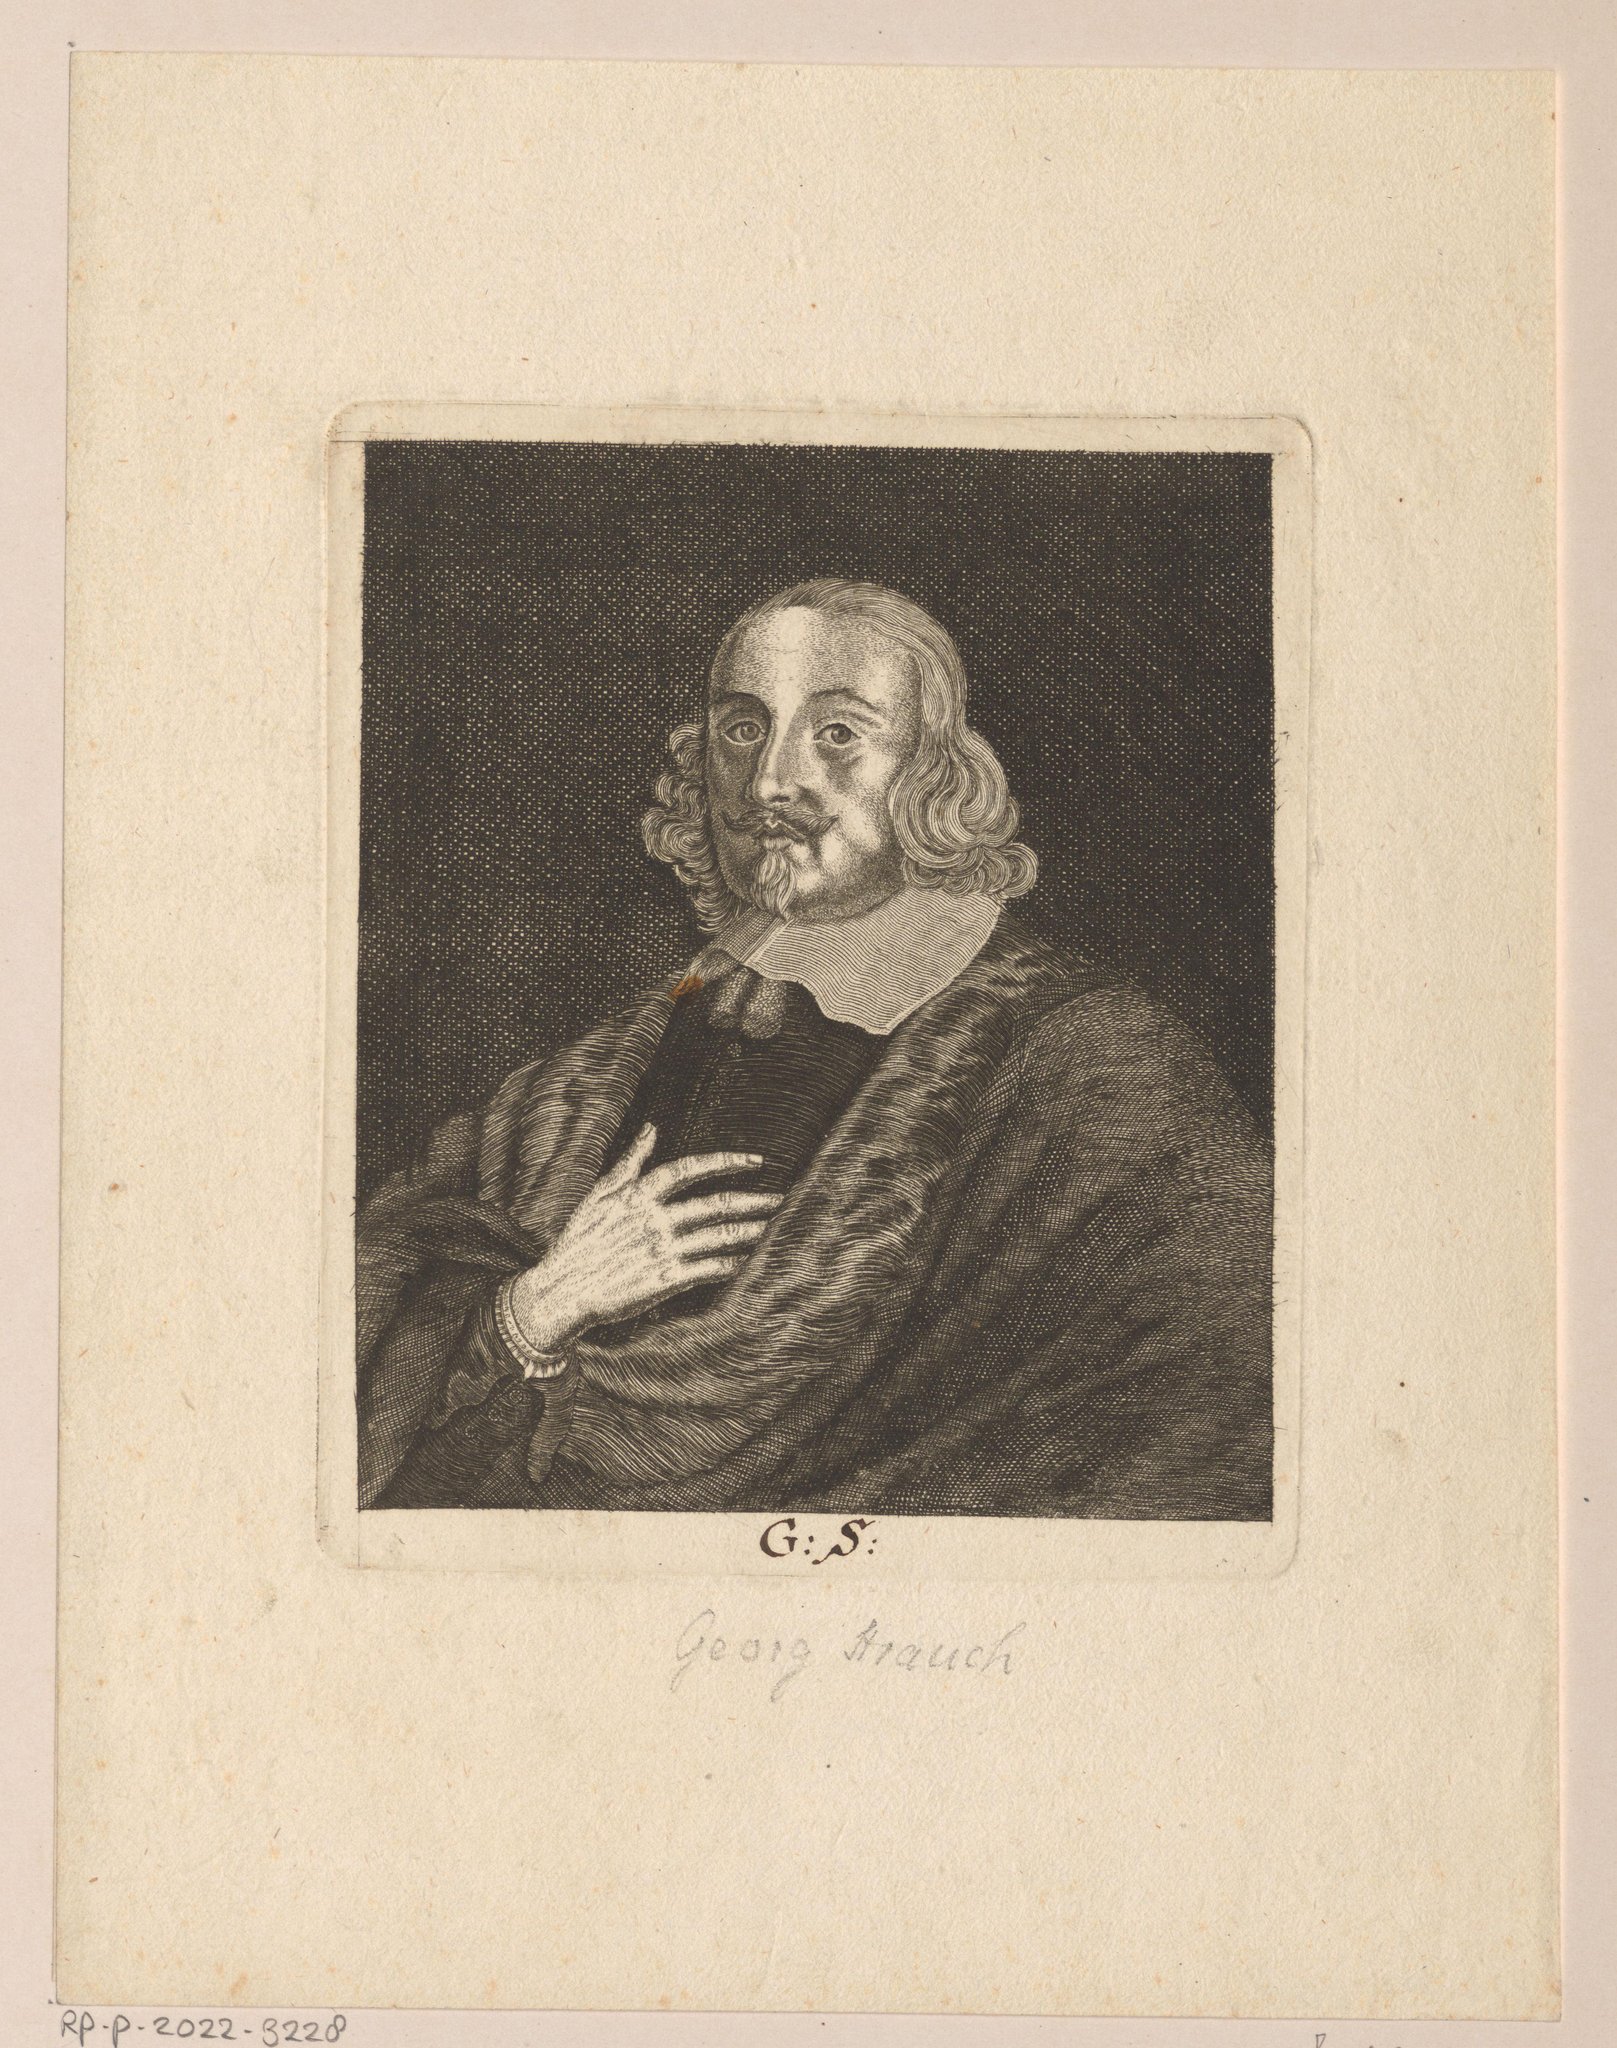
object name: print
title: Portret van Georg Strauch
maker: Anonymous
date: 1675-1725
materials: paper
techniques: engraving, etching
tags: print maker, georg strauch, historical persons, portrait, self-portrait of artist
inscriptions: initials: ‘G:S:’